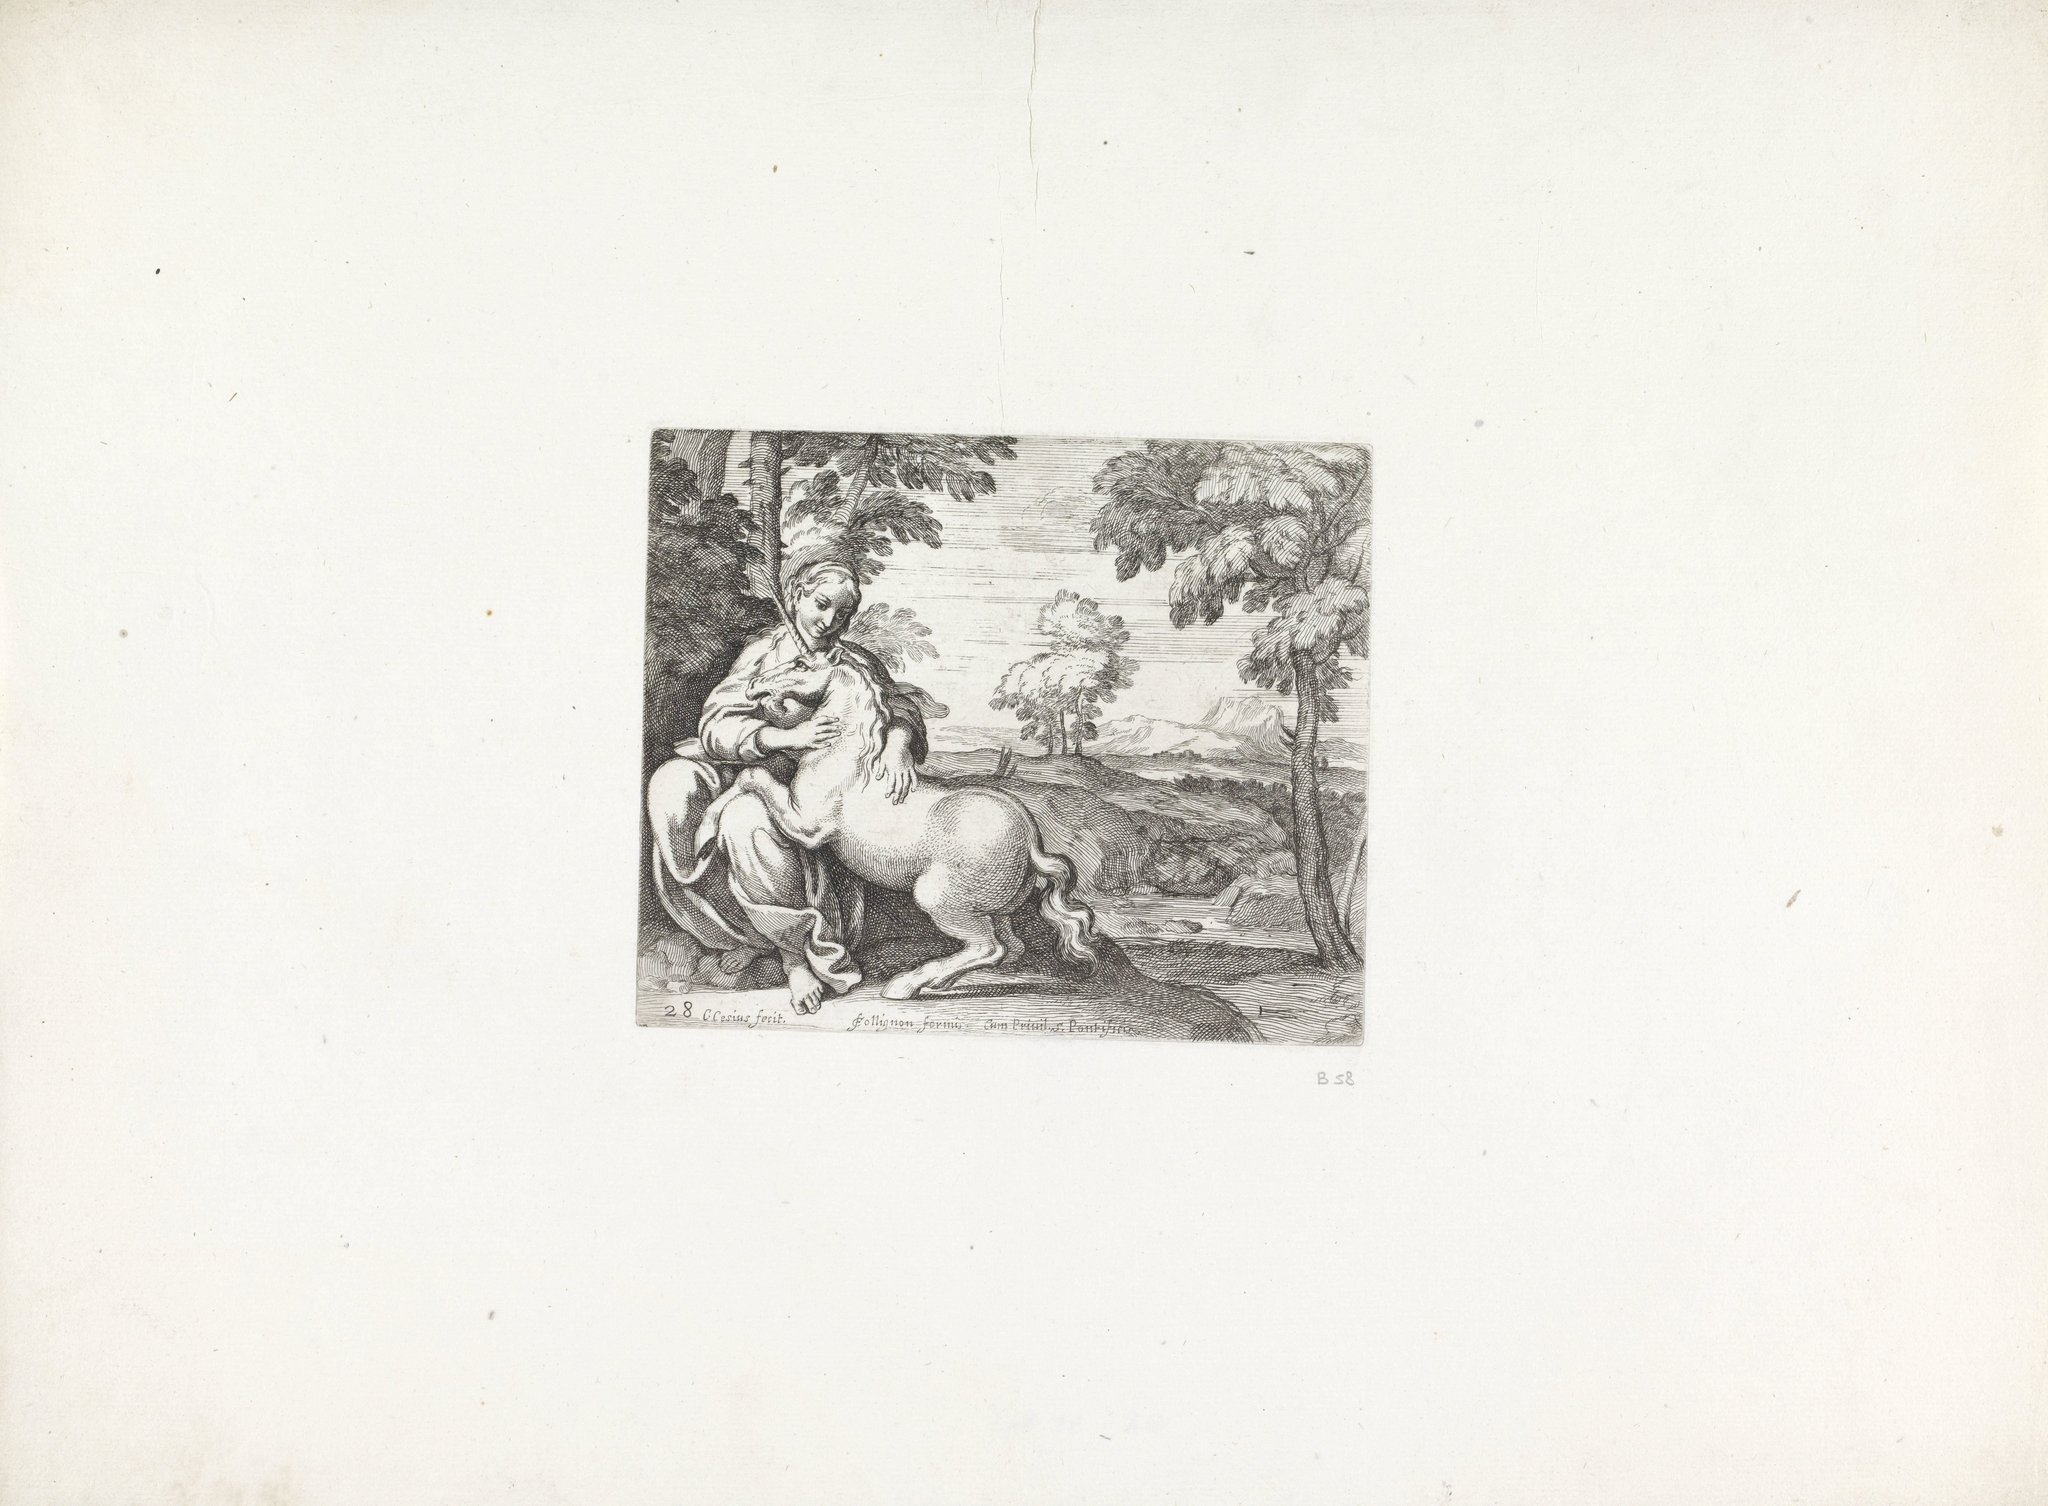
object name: print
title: Galeria nel Palazzo Farnese in Roma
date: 1656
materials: paper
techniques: etching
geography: italy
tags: unicorn, philyra beloved by saturn, occasionally in the shape of a horse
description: Prent uit een reeks prenten met nummers van 1 tot en met 29 (sommige prenten hebben hetzelfde nummer), plus titelprent en opdracht, naar schilderingen in Palazzo Farnese te Rome.